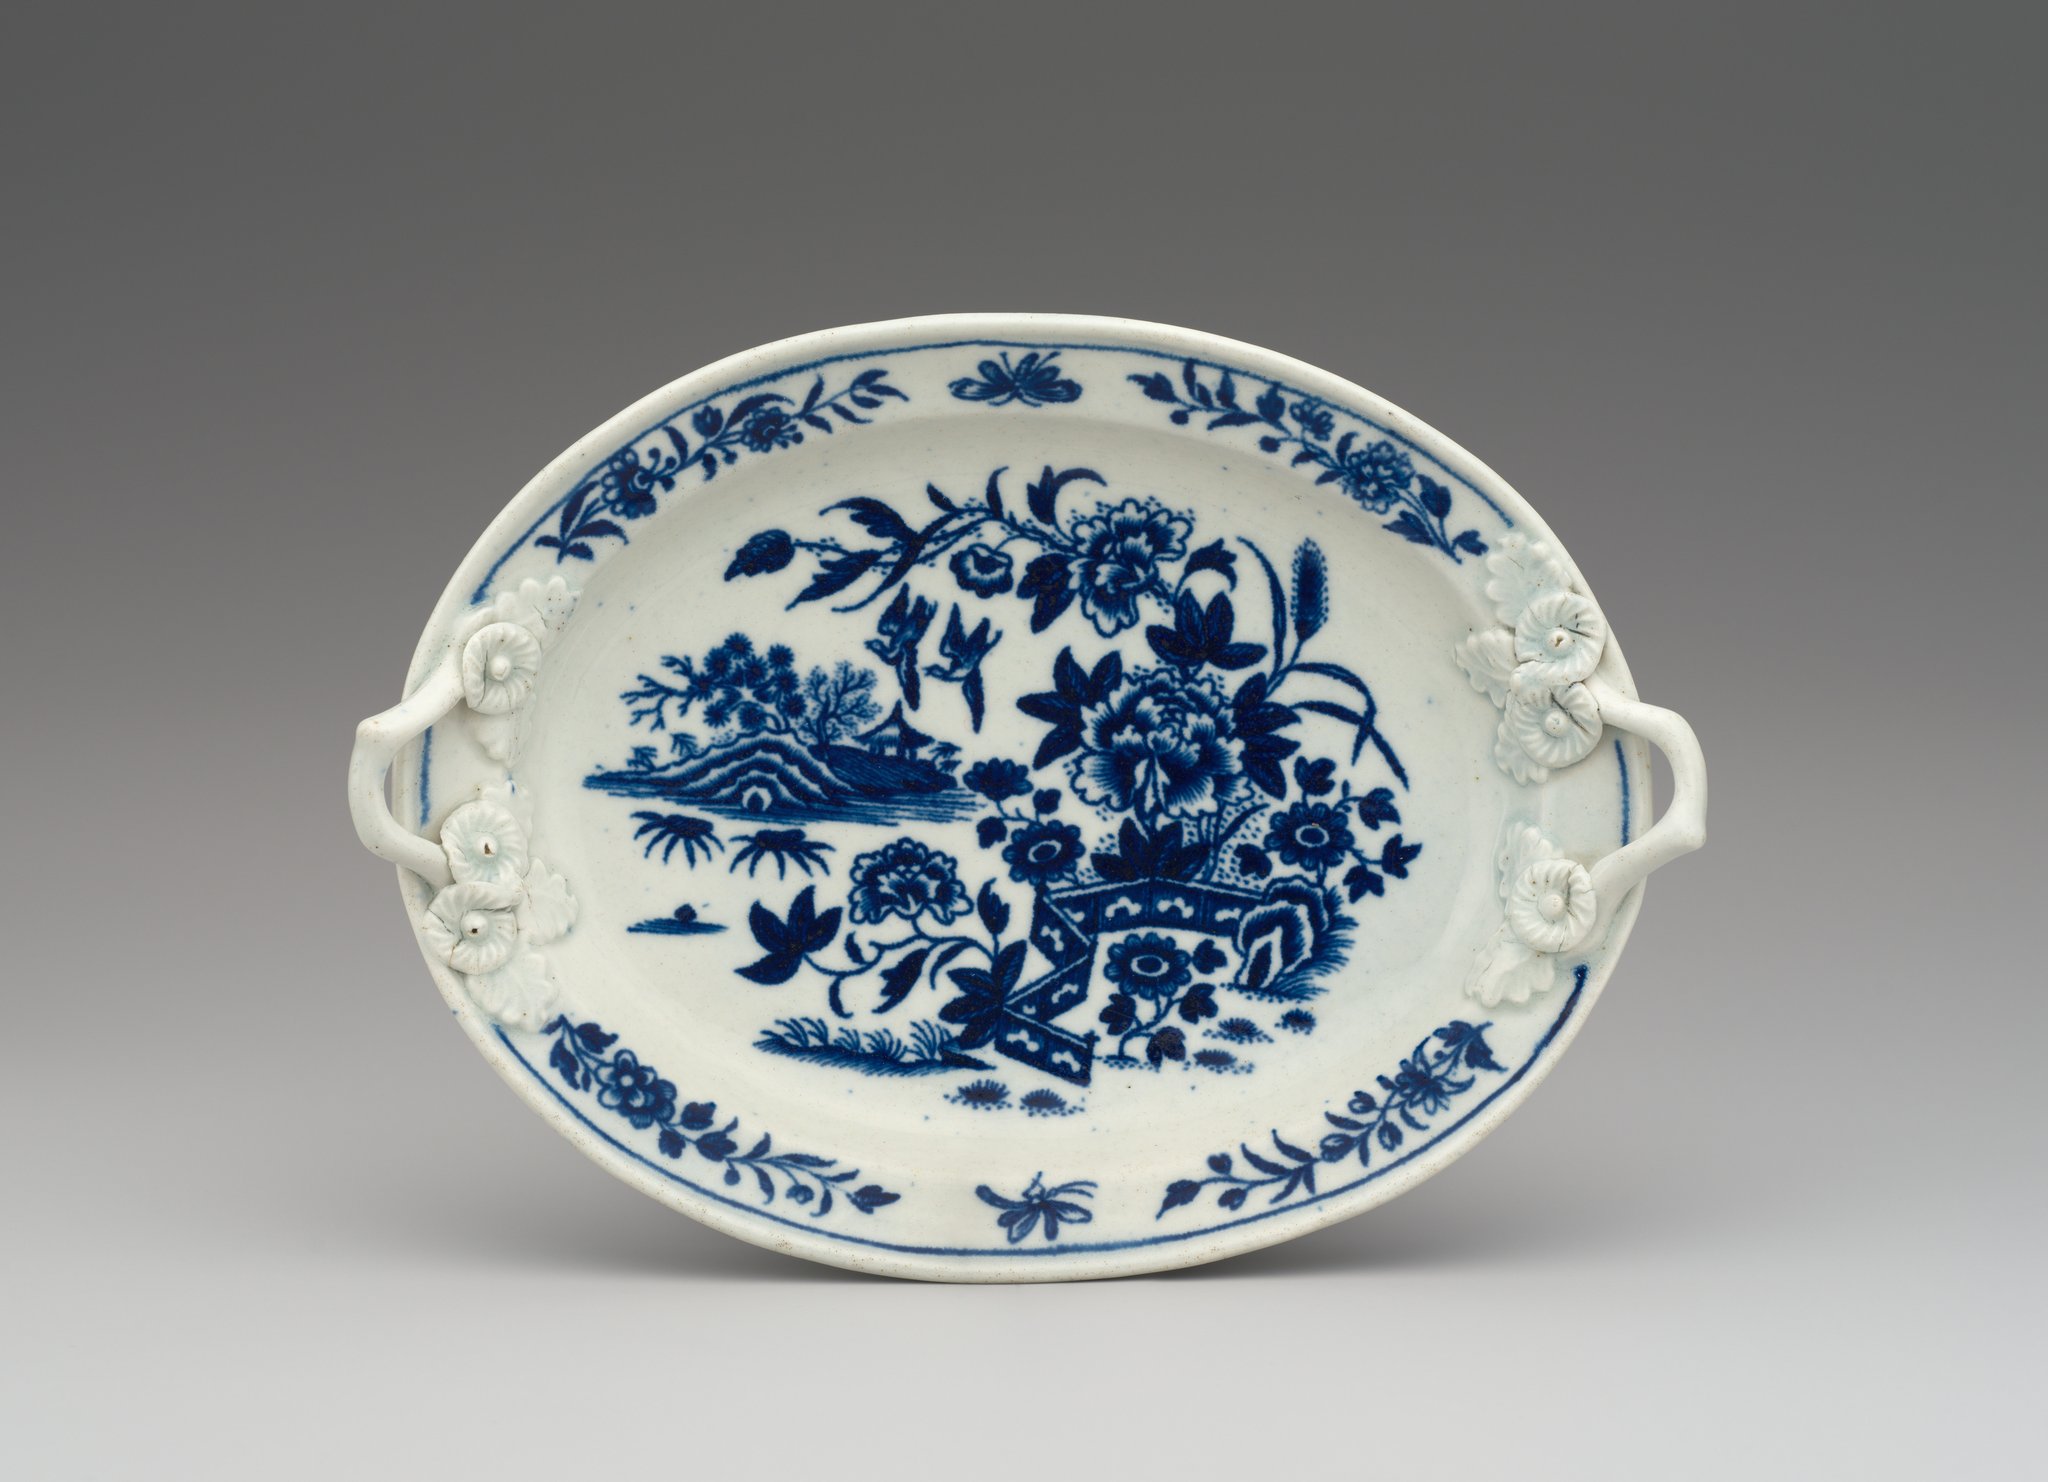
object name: dish stand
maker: worcester factory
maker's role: factory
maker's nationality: british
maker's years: 1751-2008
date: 1760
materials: soft paste porcelain